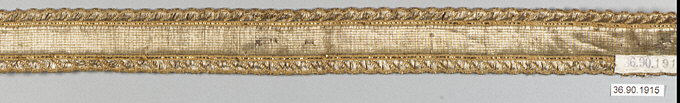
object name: galloon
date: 1801-1900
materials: metal thread